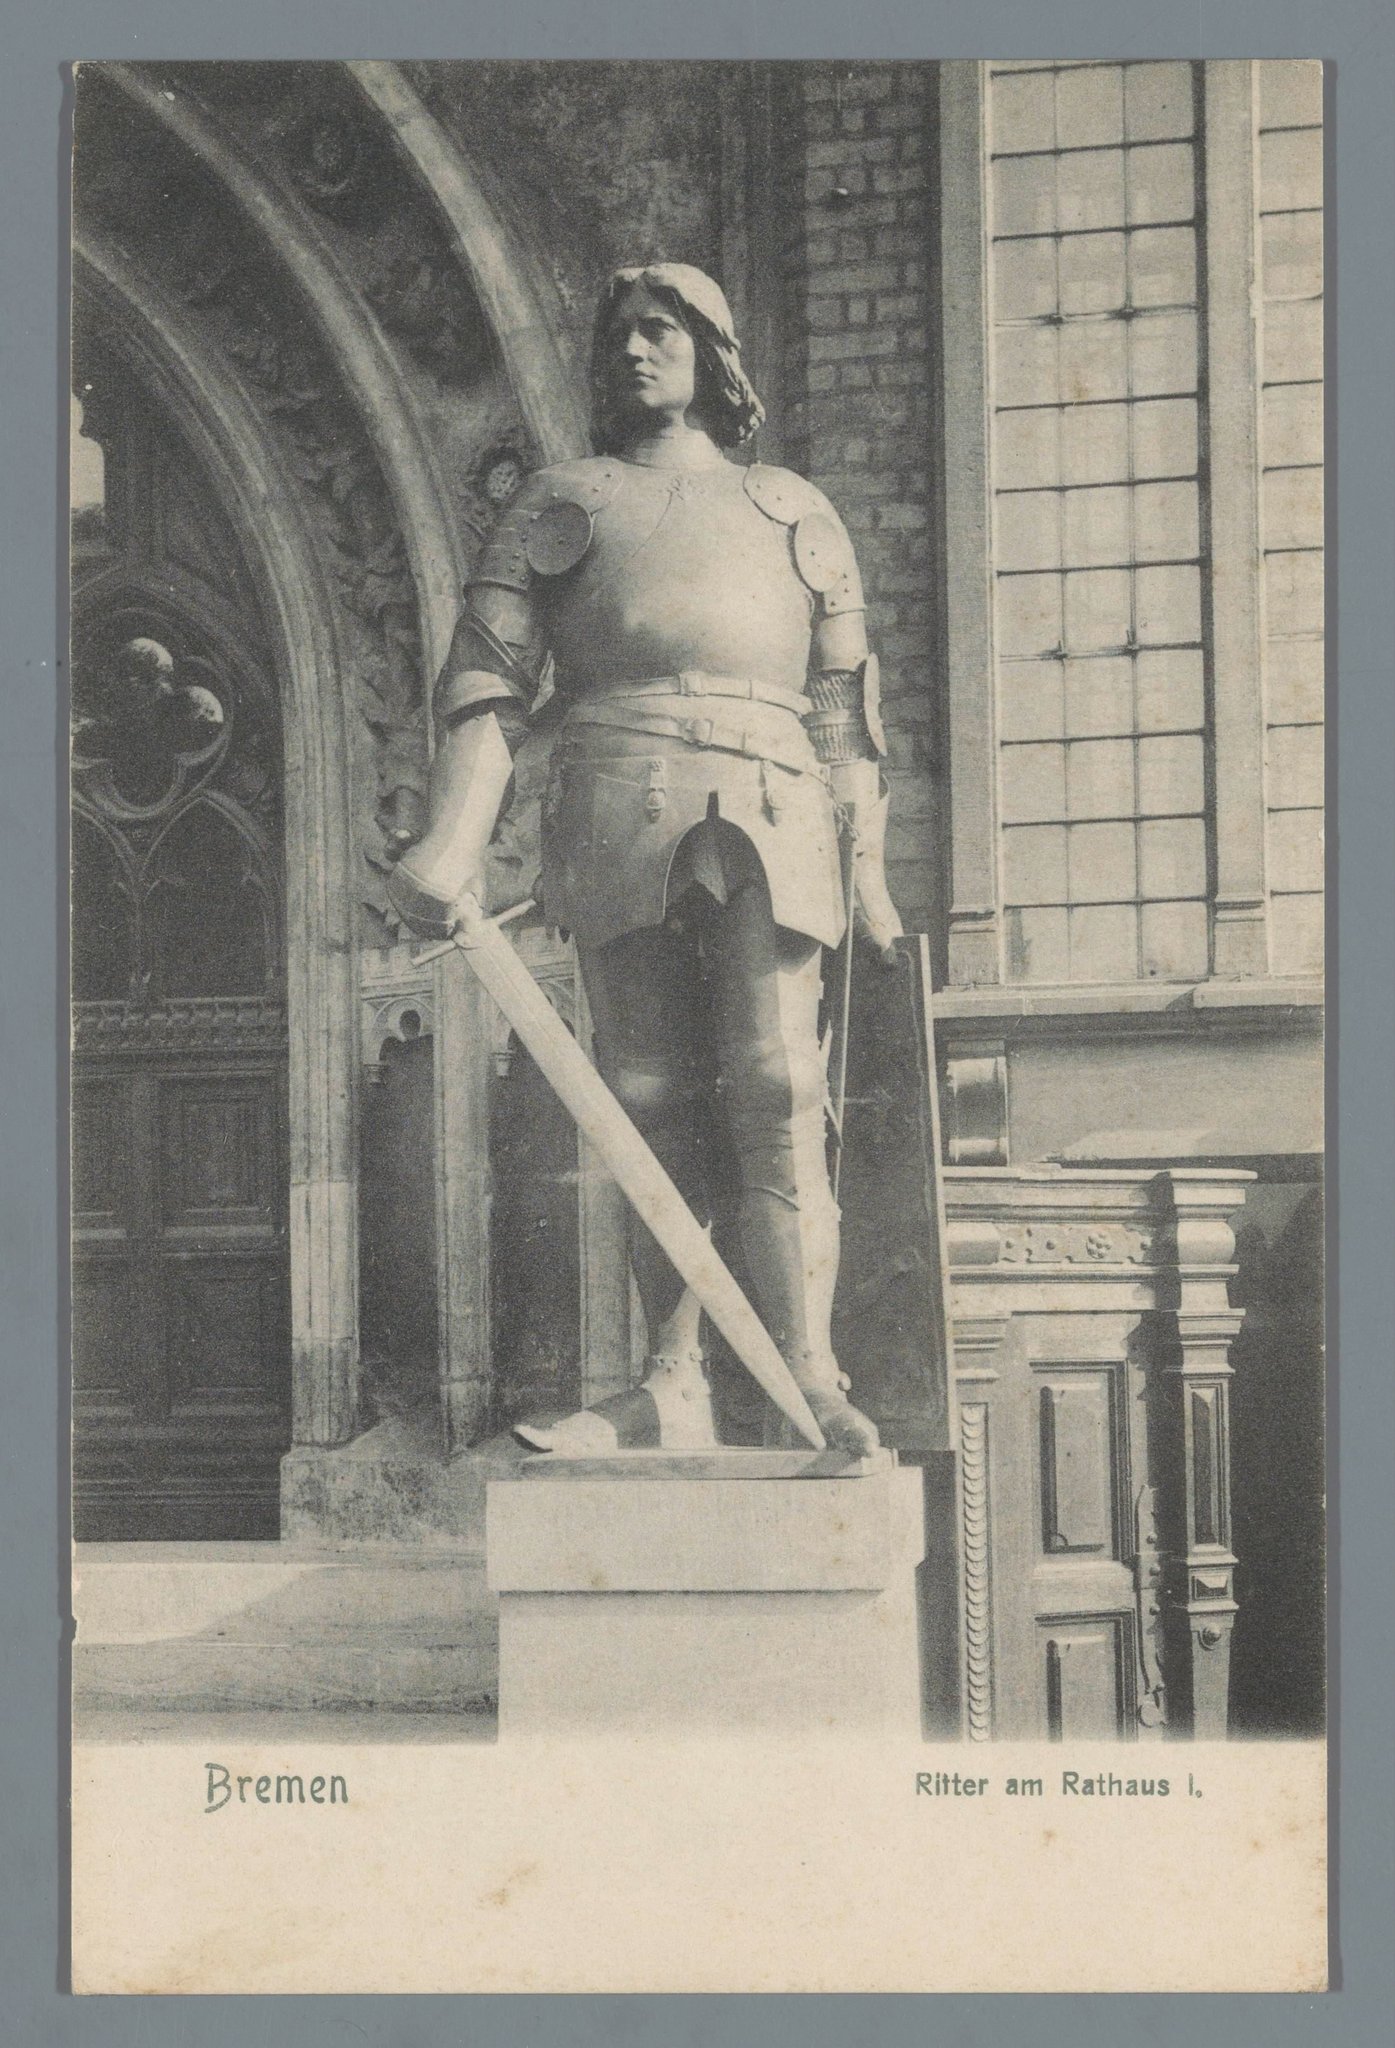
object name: photomechanical print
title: Bremen, Ritter am Rathaus I.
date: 1904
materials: paper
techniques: photograph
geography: bremen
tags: townhall, monument, statue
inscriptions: inscription: ‘Louis Koch, Photogr., Bremen 1904’